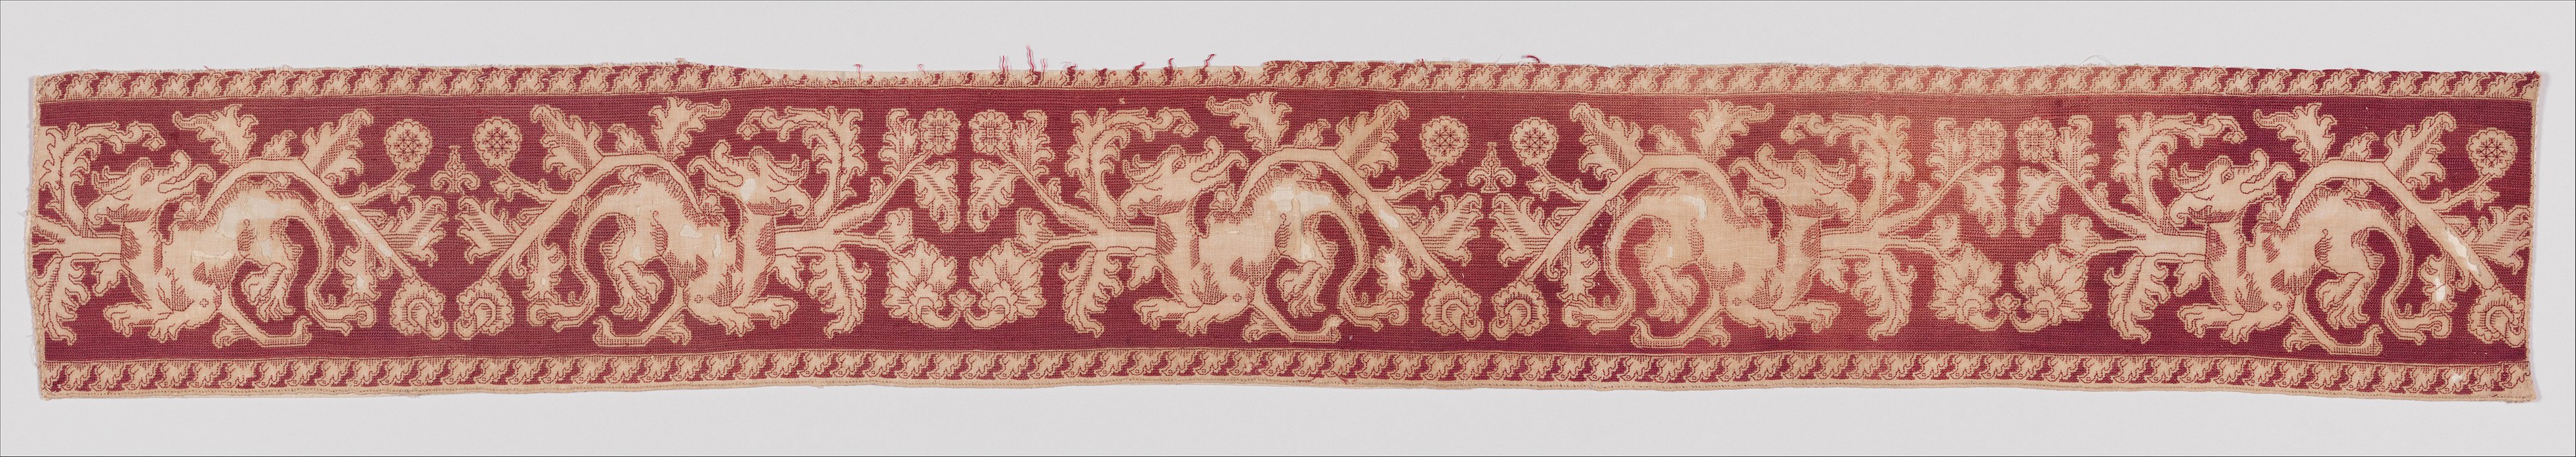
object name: border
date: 1567-1600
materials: linen, silk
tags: mythical creatures